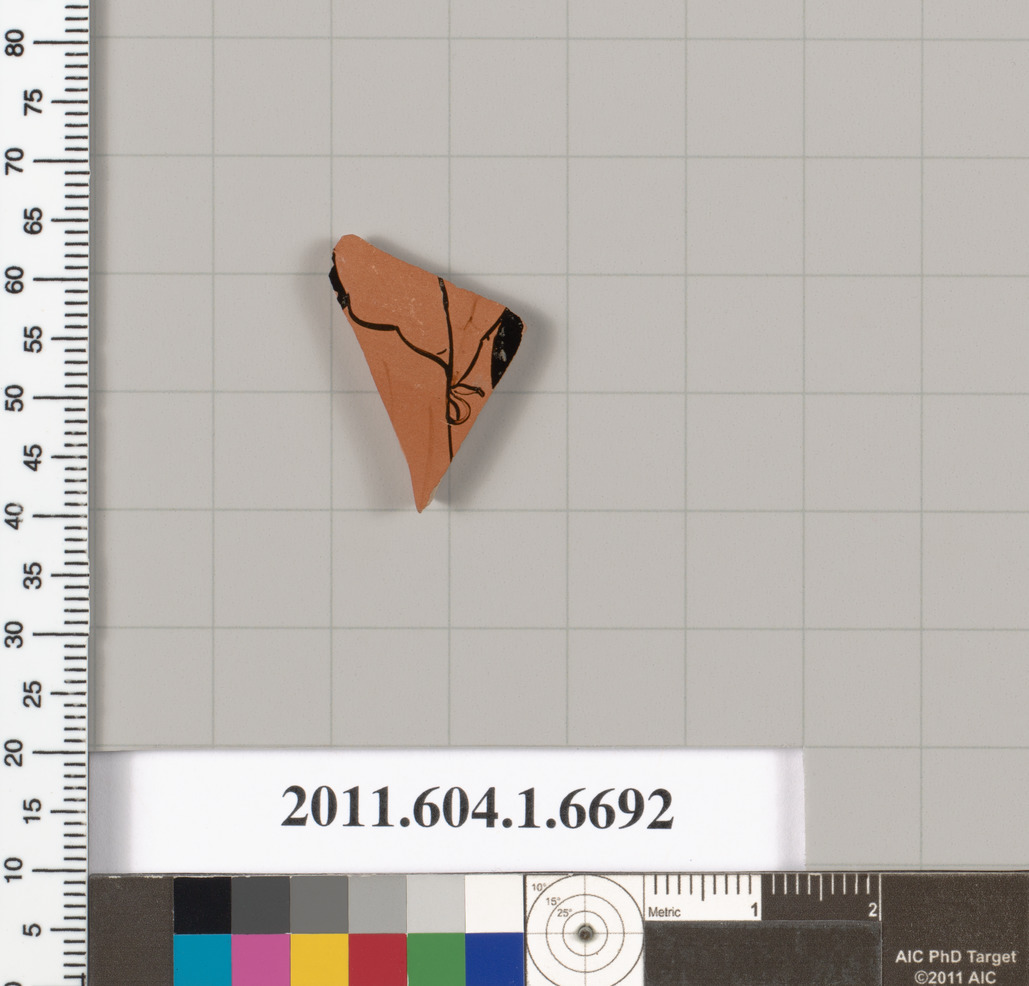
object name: kylix fragment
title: Terracotta fragment of a kylix (drinking cup)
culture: greek, attic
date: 490-470 BCE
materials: terracotta